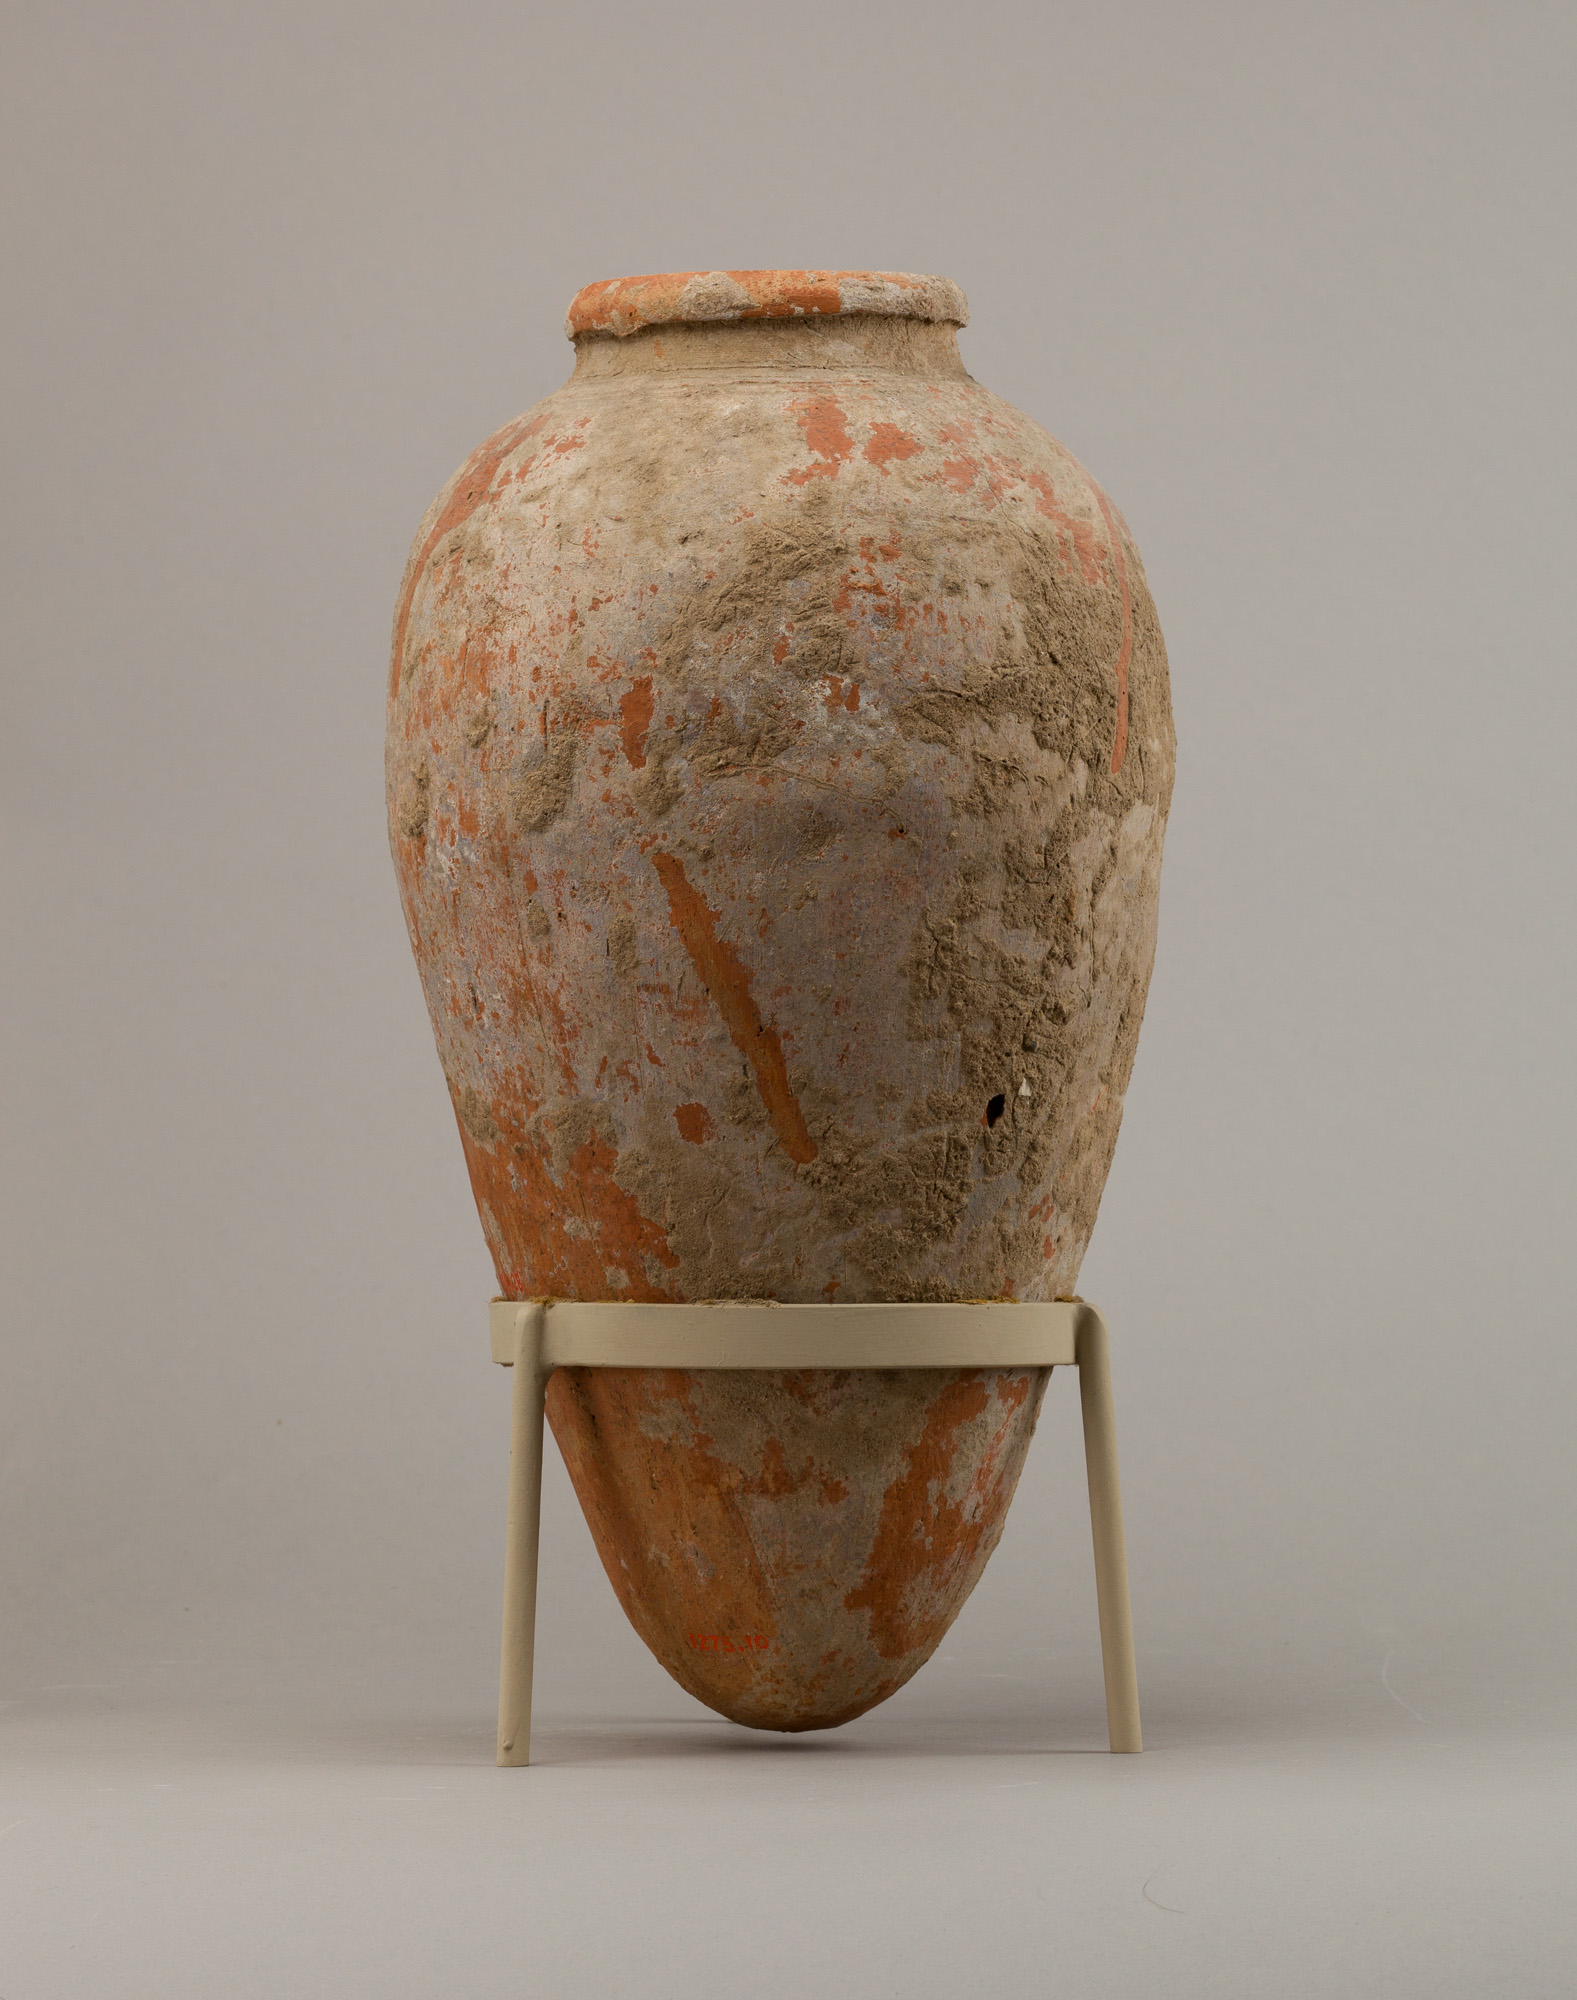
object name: jar, rough ware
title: Rough ware jar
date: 2960-2770 BCE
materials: pottery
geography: egypt